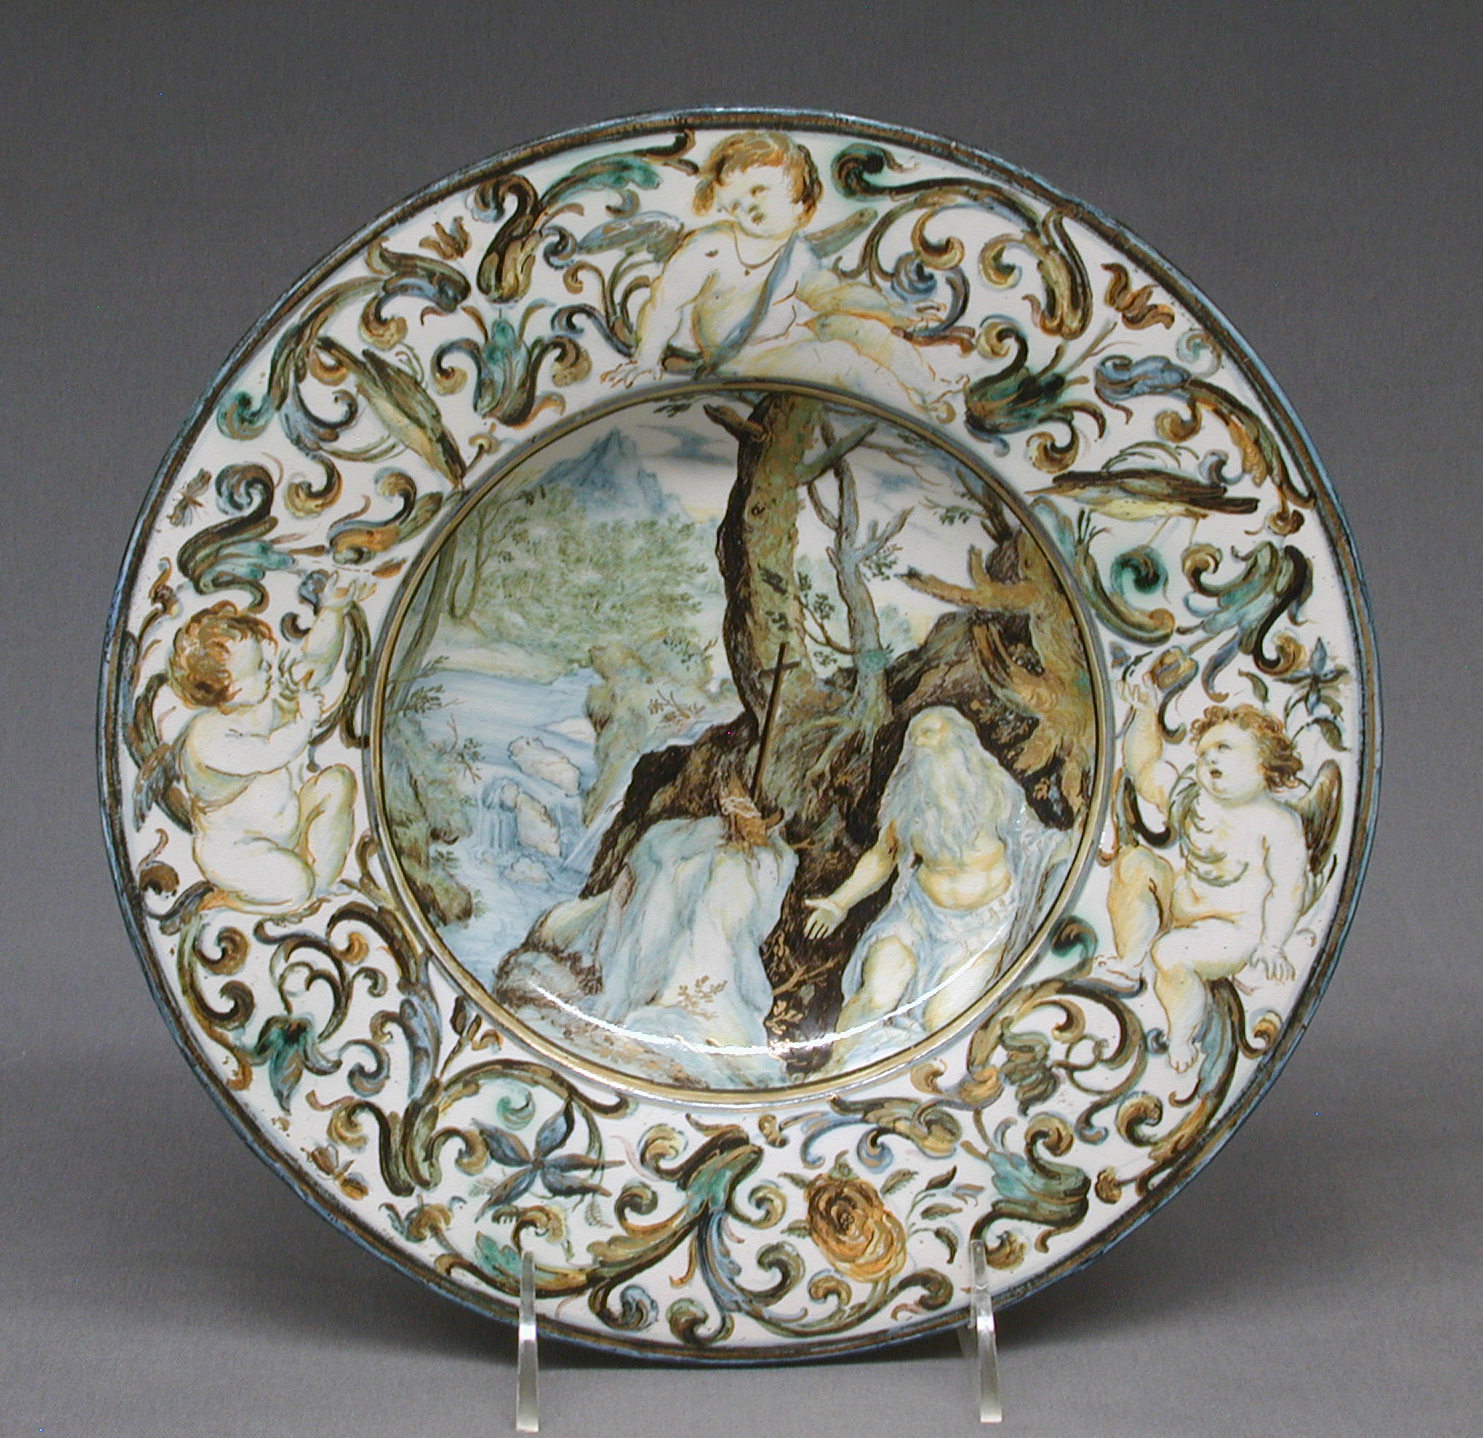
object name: plate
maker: francesco grue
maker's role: maker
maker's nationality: italian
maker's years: 1618-1673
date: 1670-1679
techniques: maiolica, glazing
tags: men,cupid